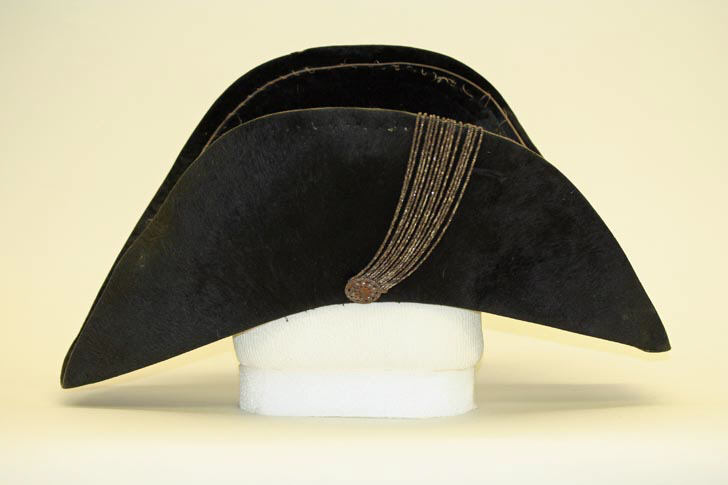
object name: hat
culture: italian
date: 1767-1833